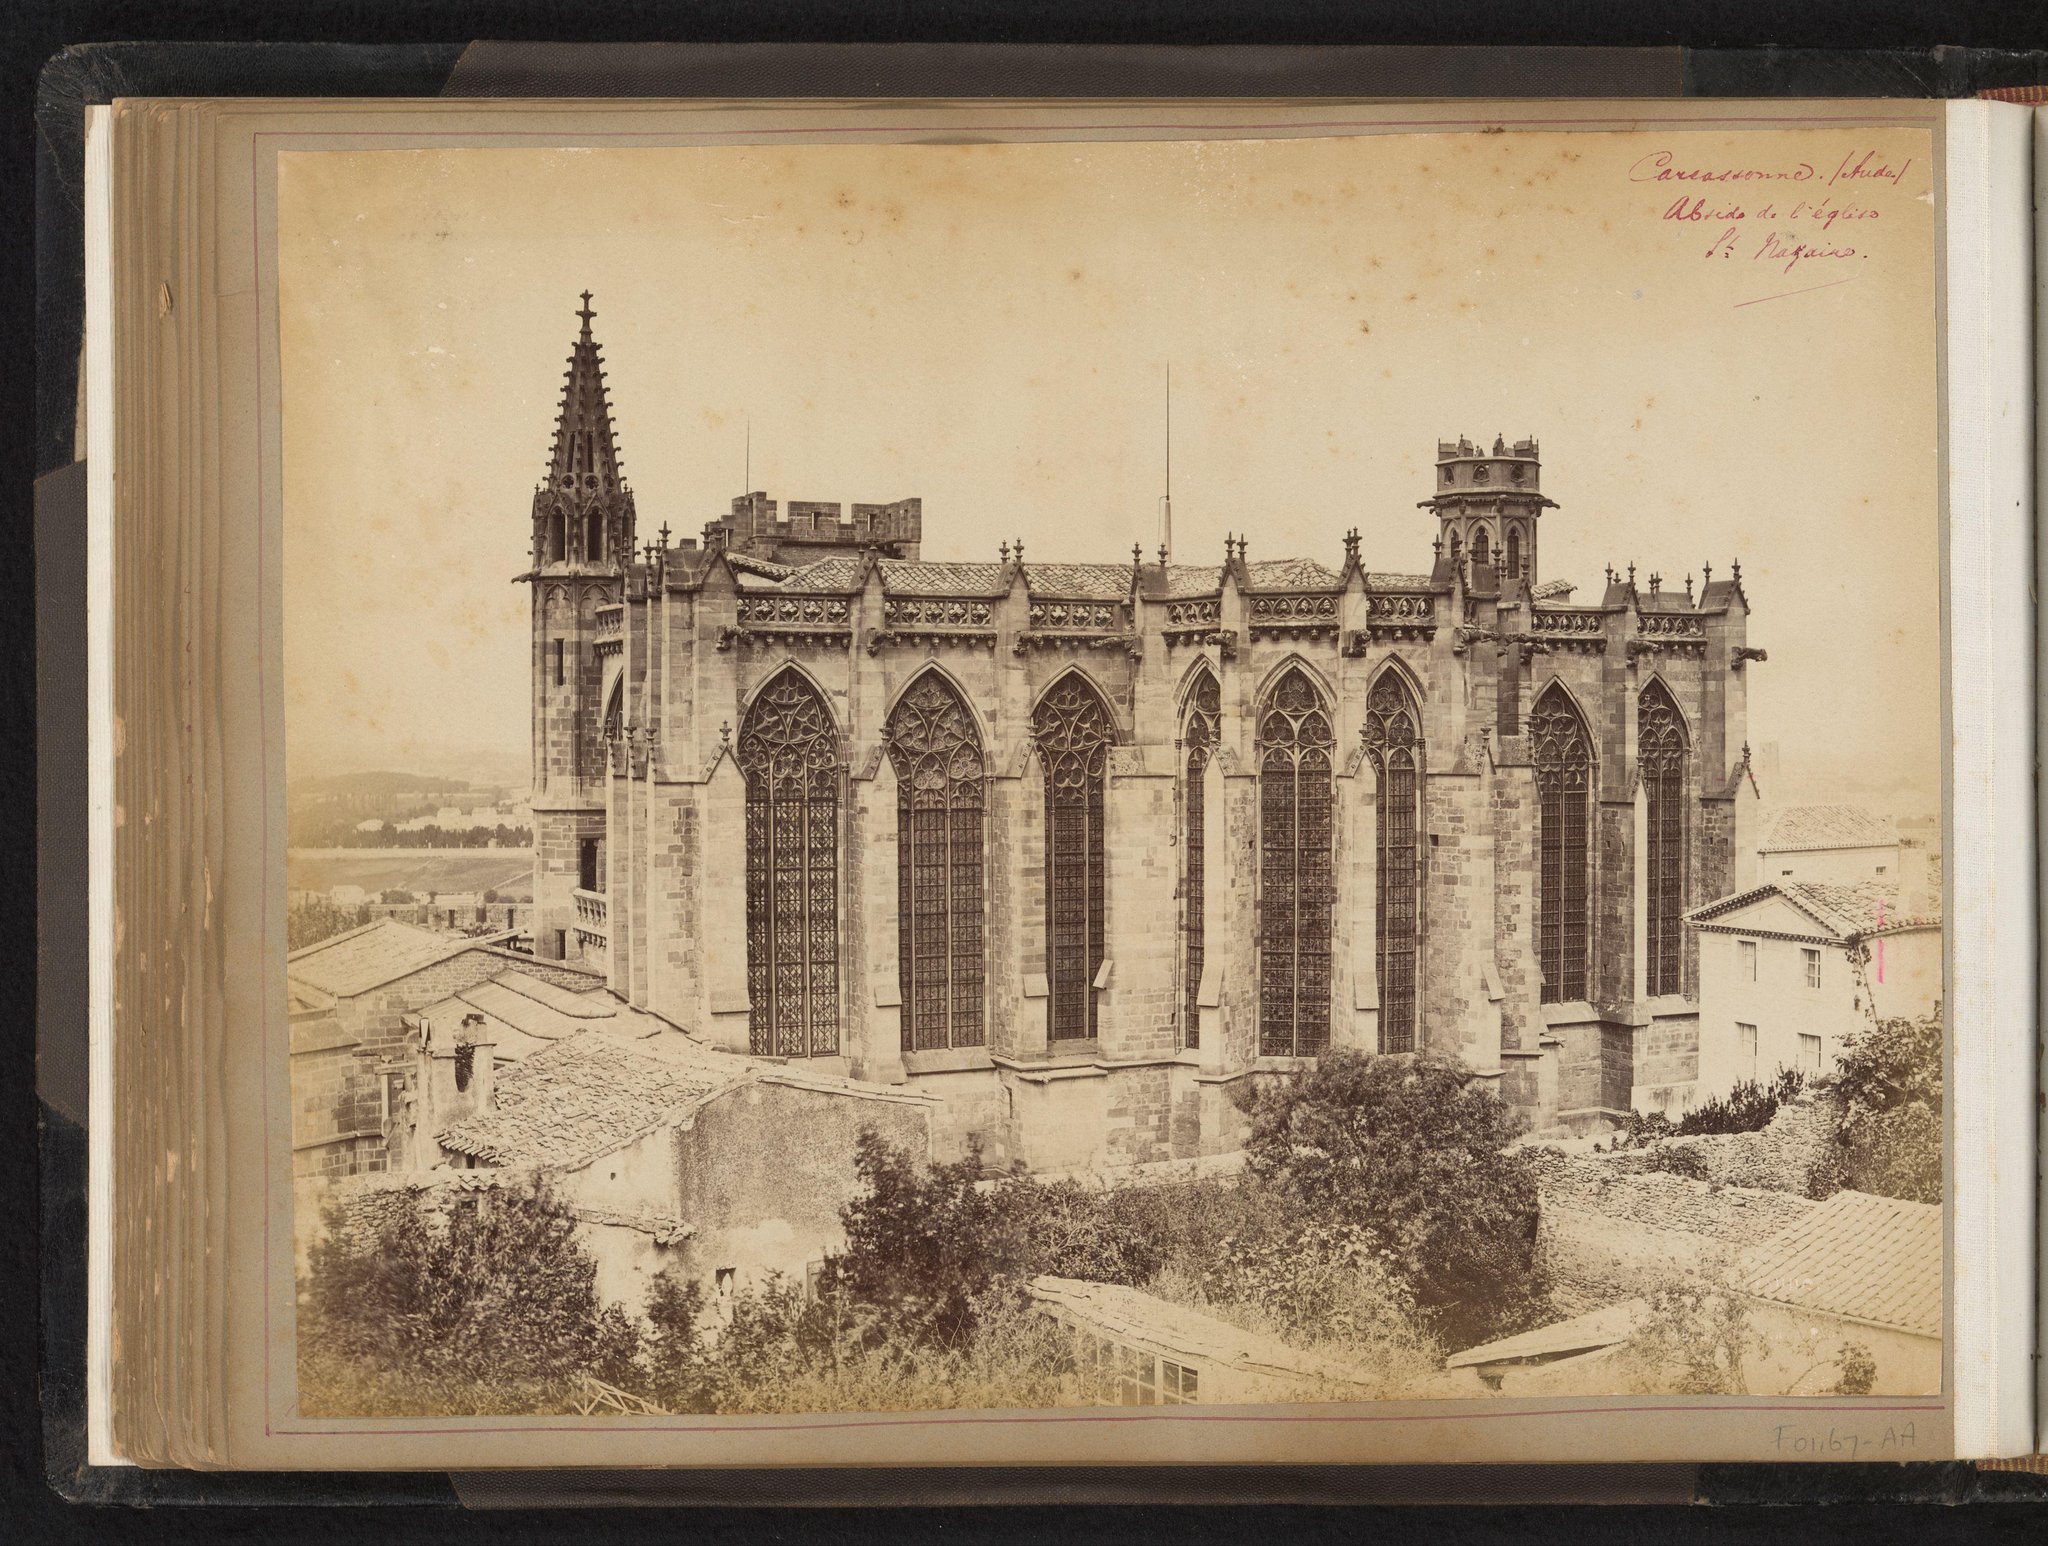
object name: album leaf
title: Église Saint-Nazaire te Carcassonne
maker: adolphe giraudon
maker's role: publisher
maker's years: 1849-1929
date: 1880-1910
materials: photographic support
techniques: albumen print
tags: church (exterior)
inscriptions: annotation: ‘Carcassonne/ [...] de l'église St. Nazaire’